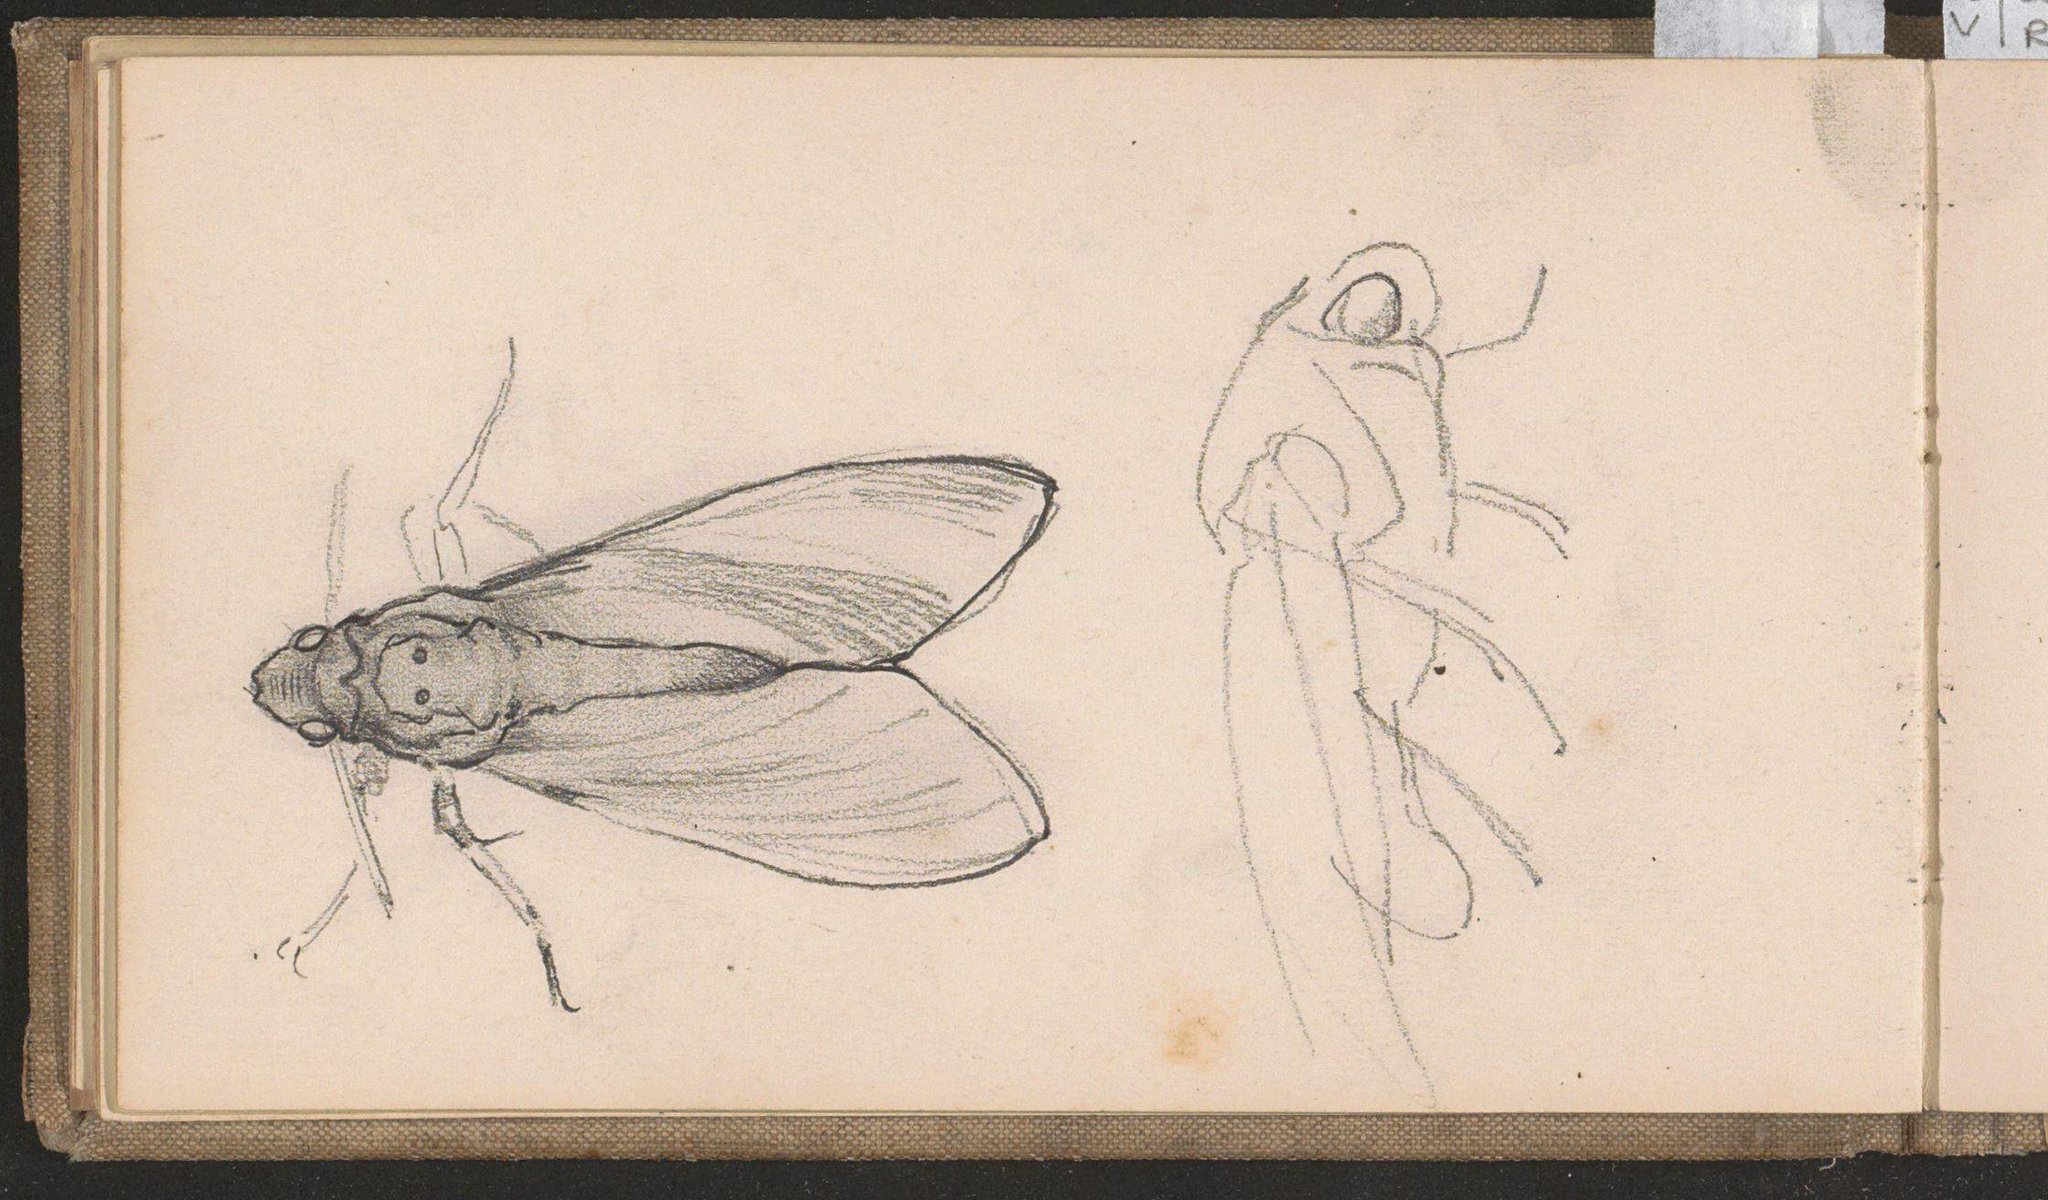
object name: sketchbook leaf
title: Vliegen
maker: antoon derkinderen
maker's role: draughtsman, painter, print maker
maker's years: 1859-1925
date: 1892-1901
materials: paper, pencil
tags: insects: fly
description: Blad 17 verso uit een schetsboek met 51 bladen.